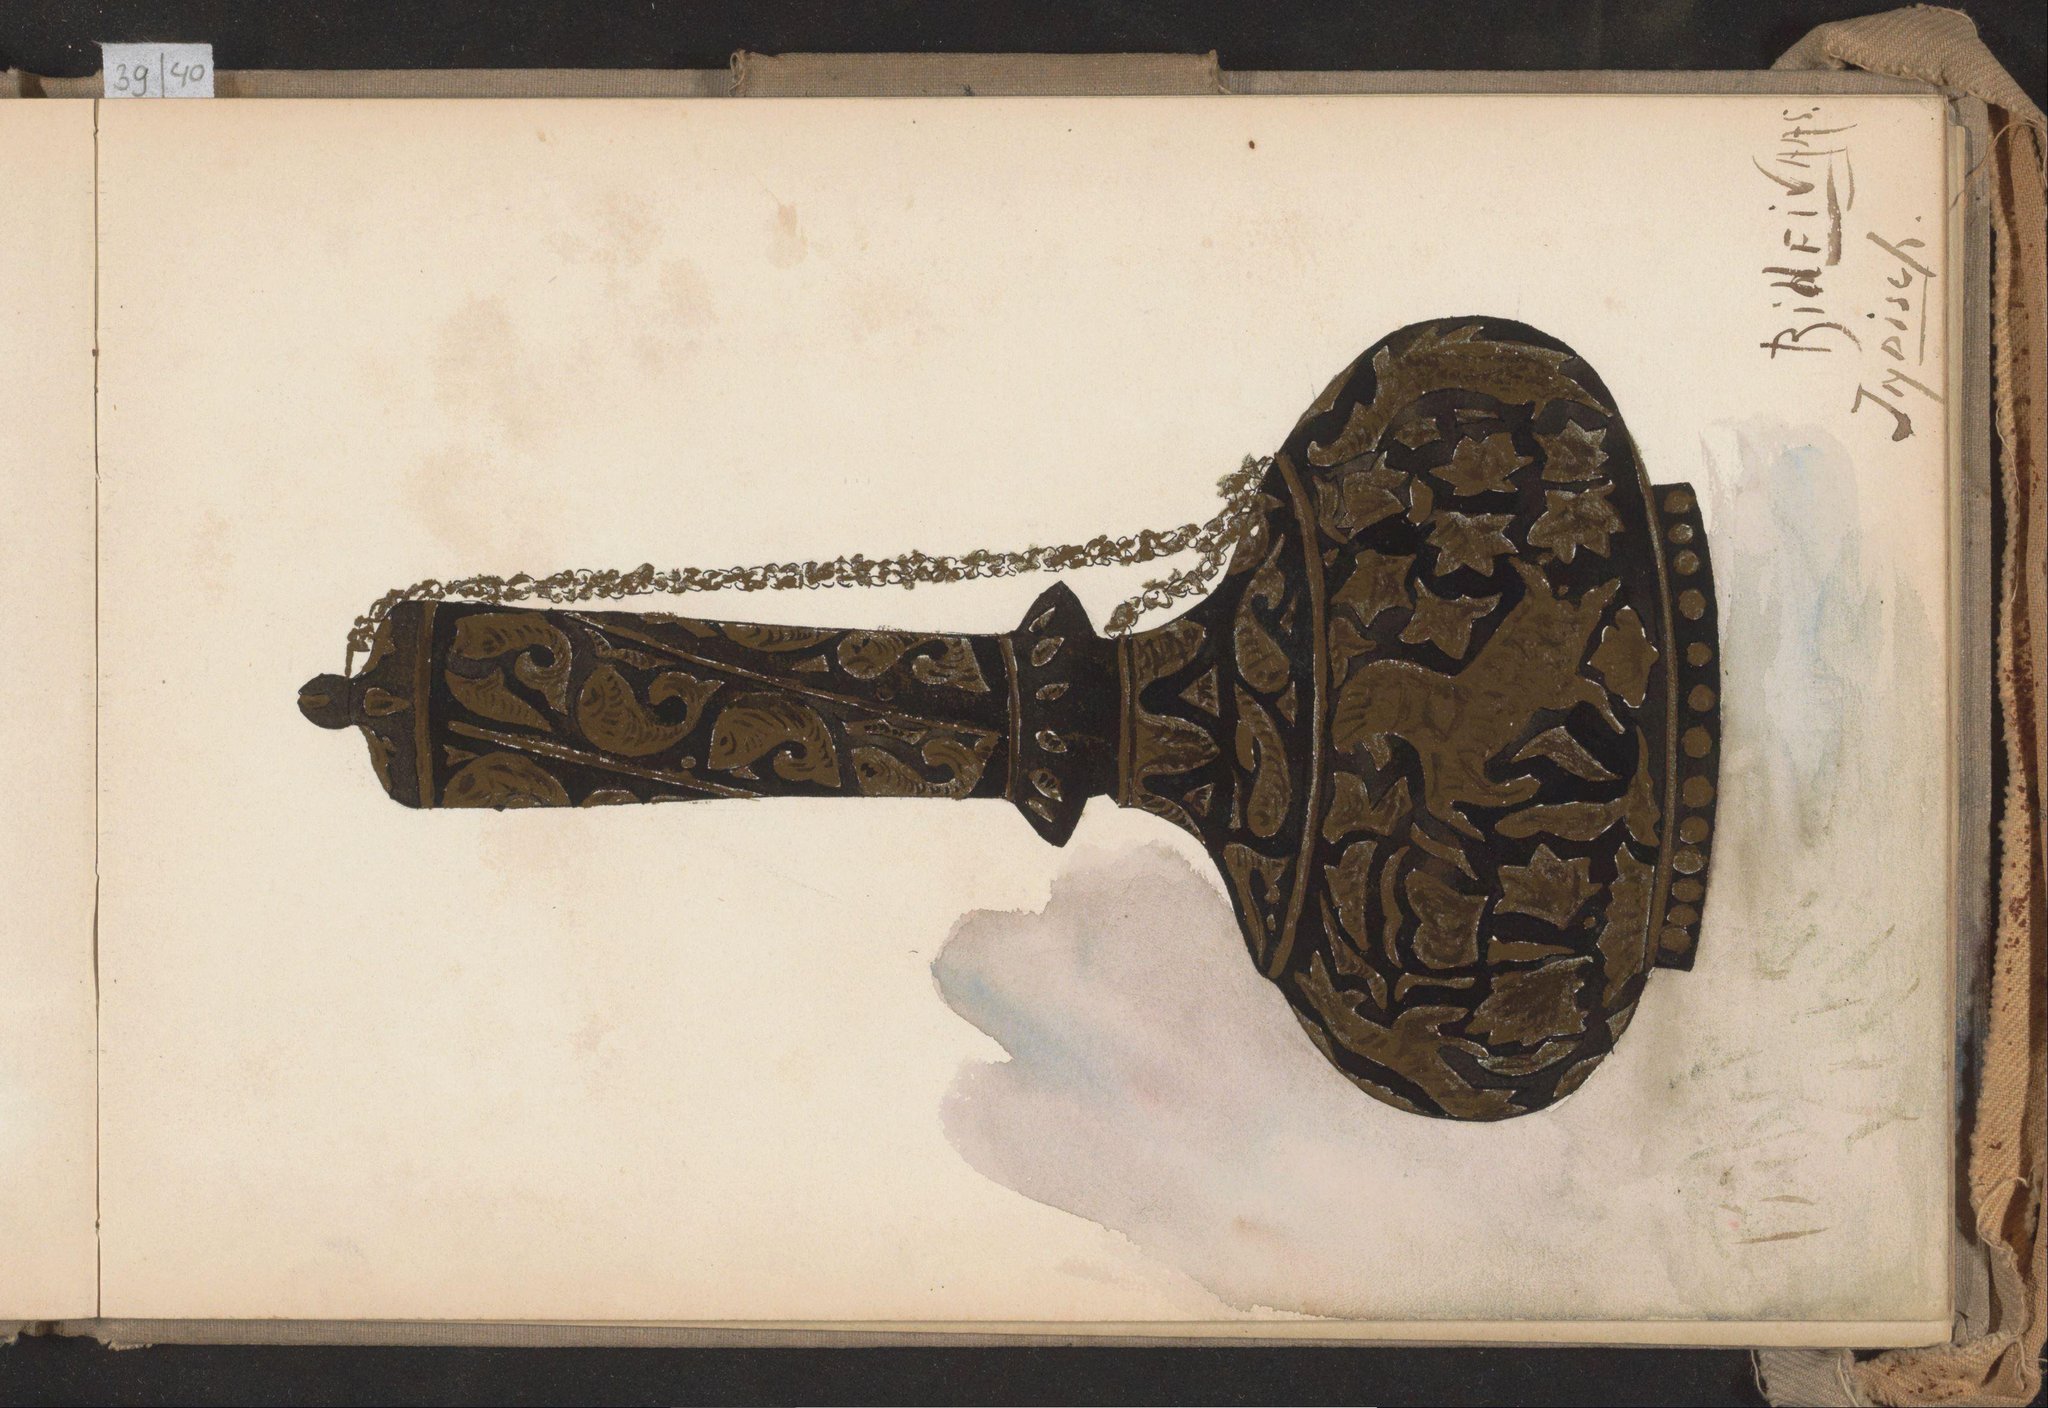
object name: sketchbook leaf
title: Indische vaas versierd met patronen van vissen en dieren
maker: johanna van de kamer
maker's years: 1873-1922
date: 1890-1922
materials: paint, ink, paper, watercolor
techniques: brush, pen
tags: ornament derived from animal forms, container of ceramics: jar, jug, pot, vase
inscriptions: annotation: ‘[...]/ B?i[...]FIVAAS/ Indisch.’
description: Blad 38 recto uit een schetsboek met 49 bladen.